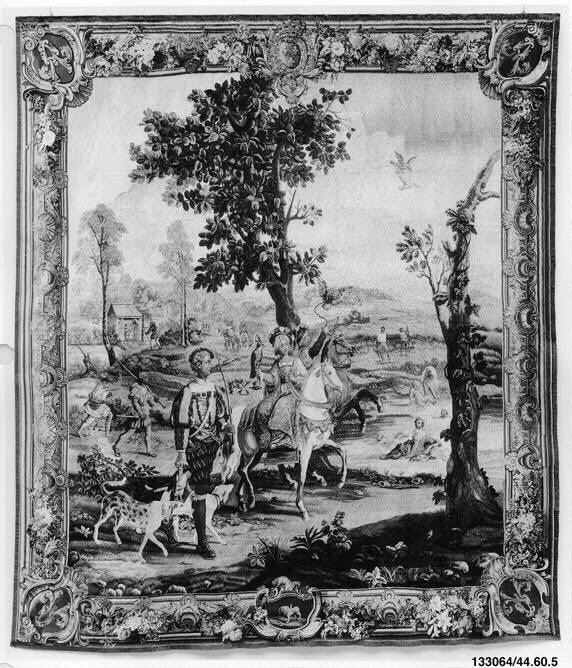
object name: tapestry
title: July from a set of The Months of Lucas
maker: master of the months of lucas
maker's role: designer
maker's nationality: netherlandish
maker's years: 1535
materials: silk, wool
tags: animals,men,horses,plants